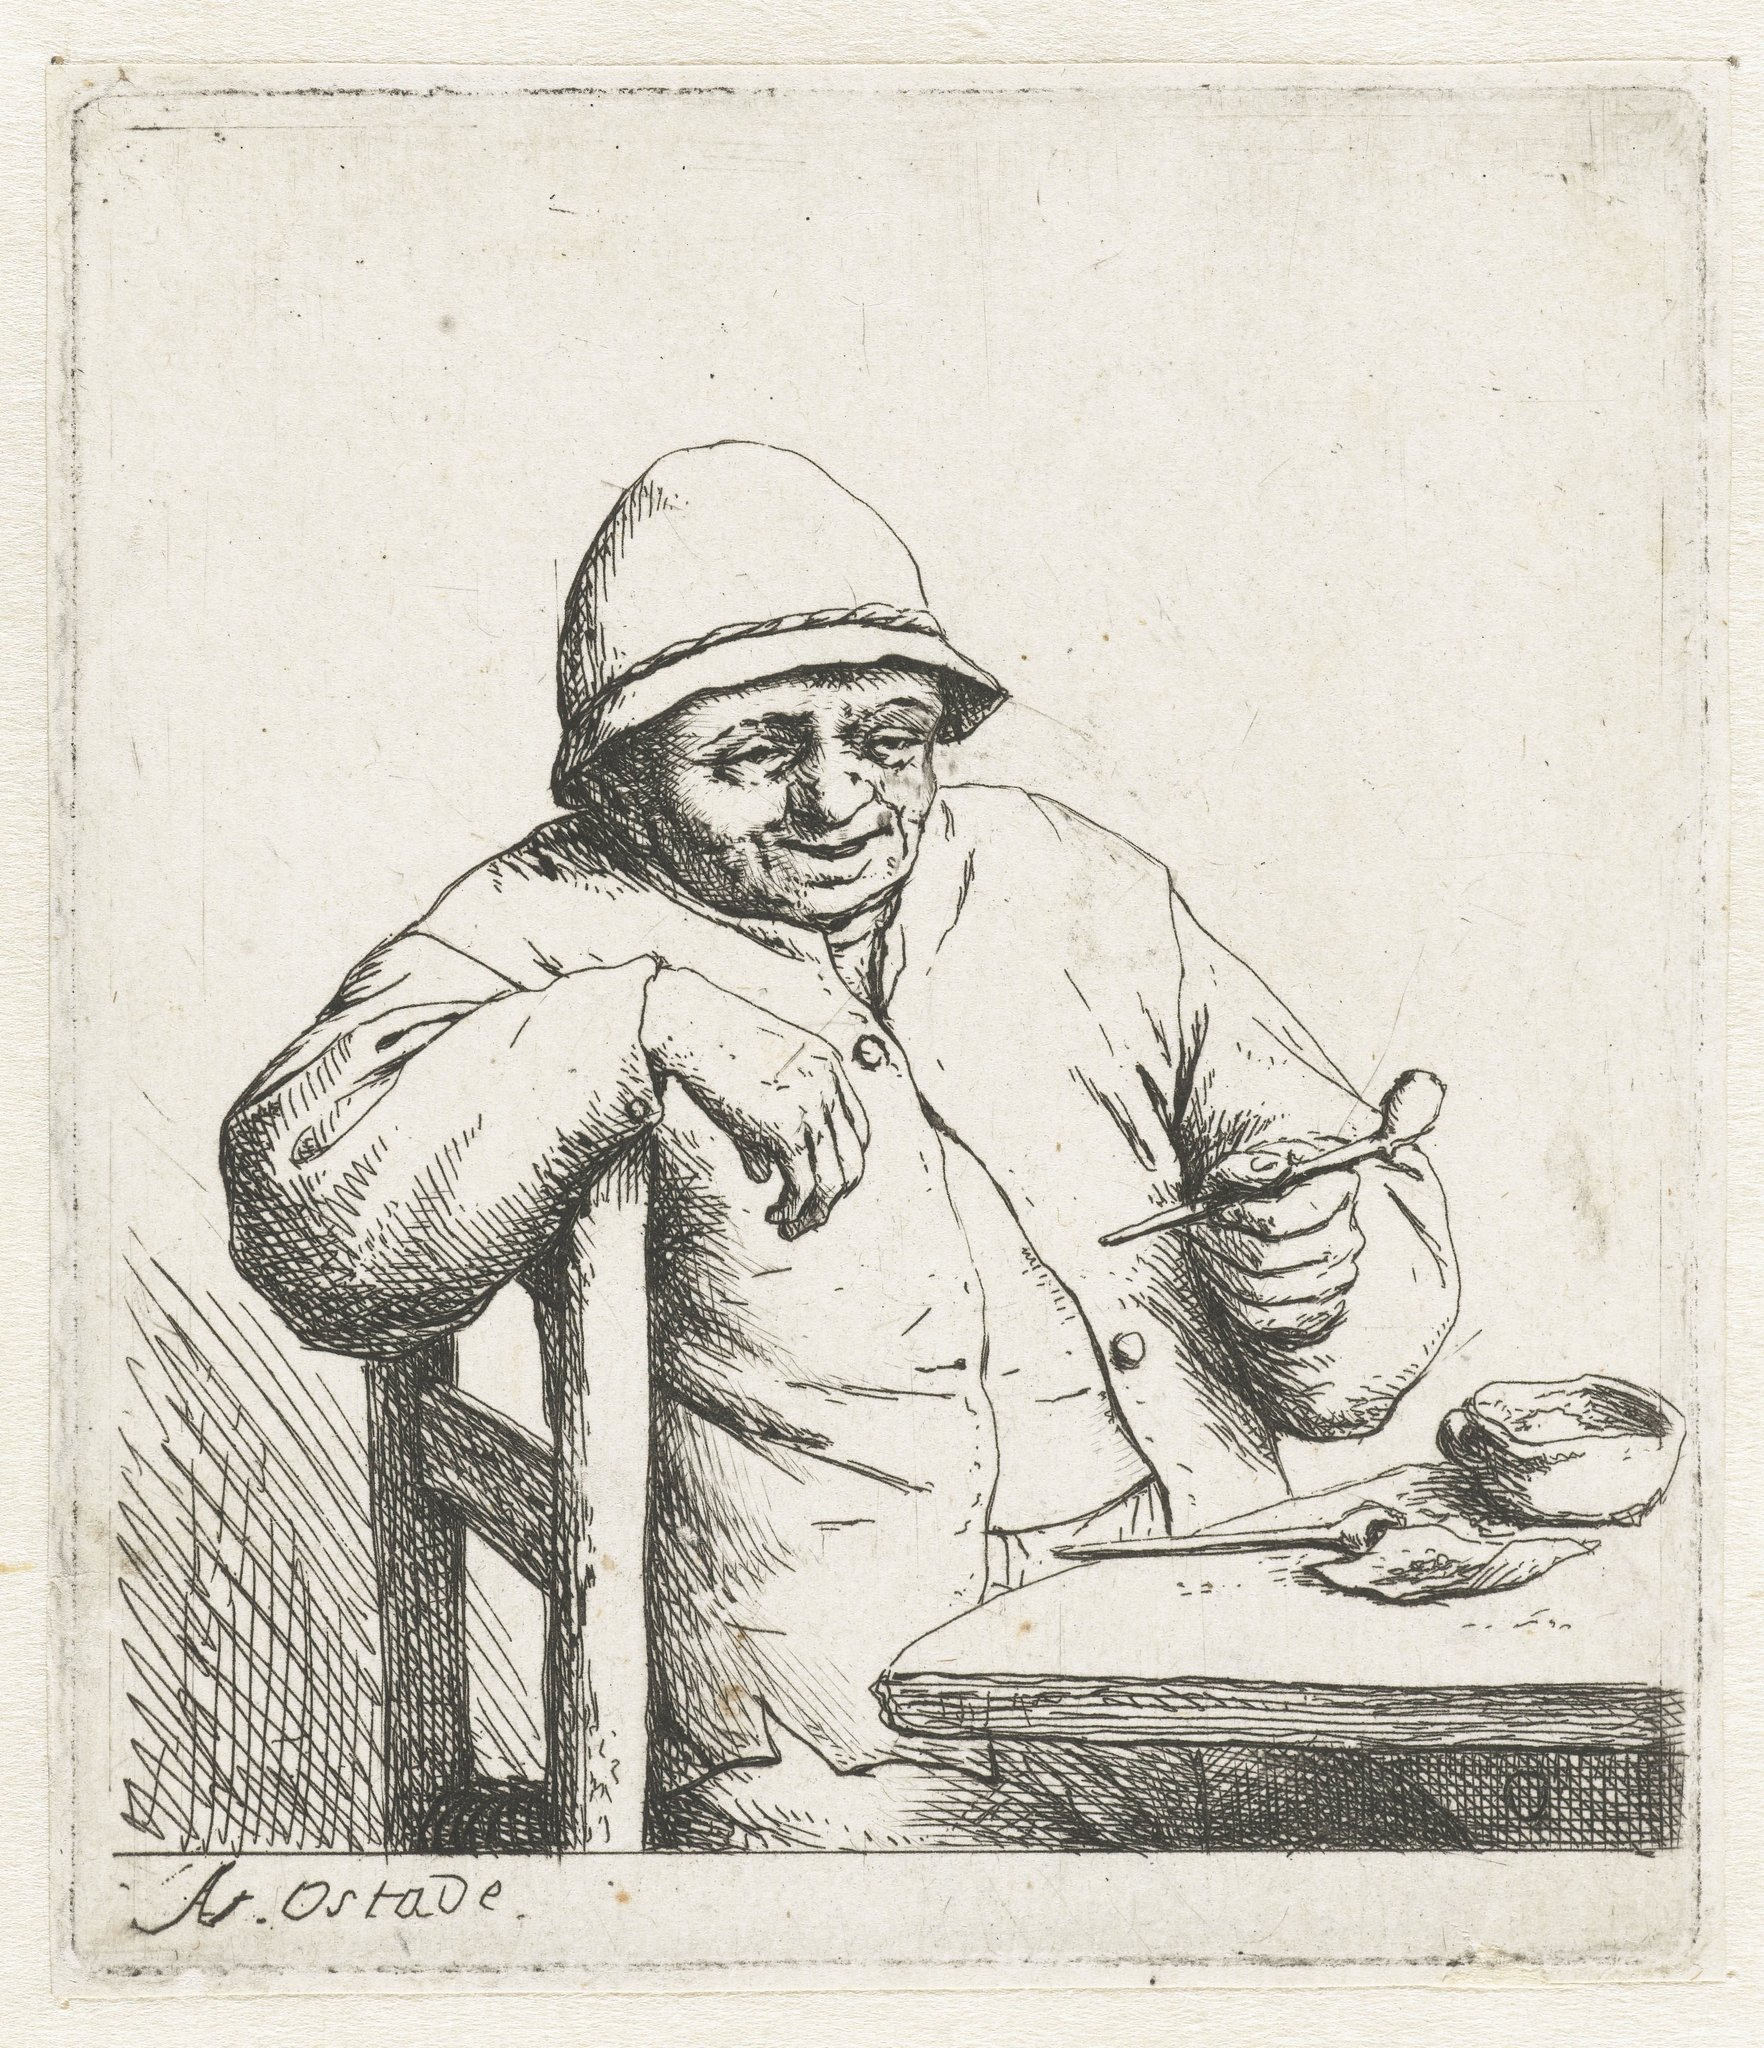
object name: print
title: Rokende boer met de arm over een stoelleuning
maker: adriaen van ostade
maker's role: draughtsman, painter, print maker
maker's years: 1610-1685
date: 1650-1654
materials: paper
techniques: etching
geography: haarlem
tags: pipe ~ tobacco, male sex; man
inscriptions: collector's mark: Lugt 240